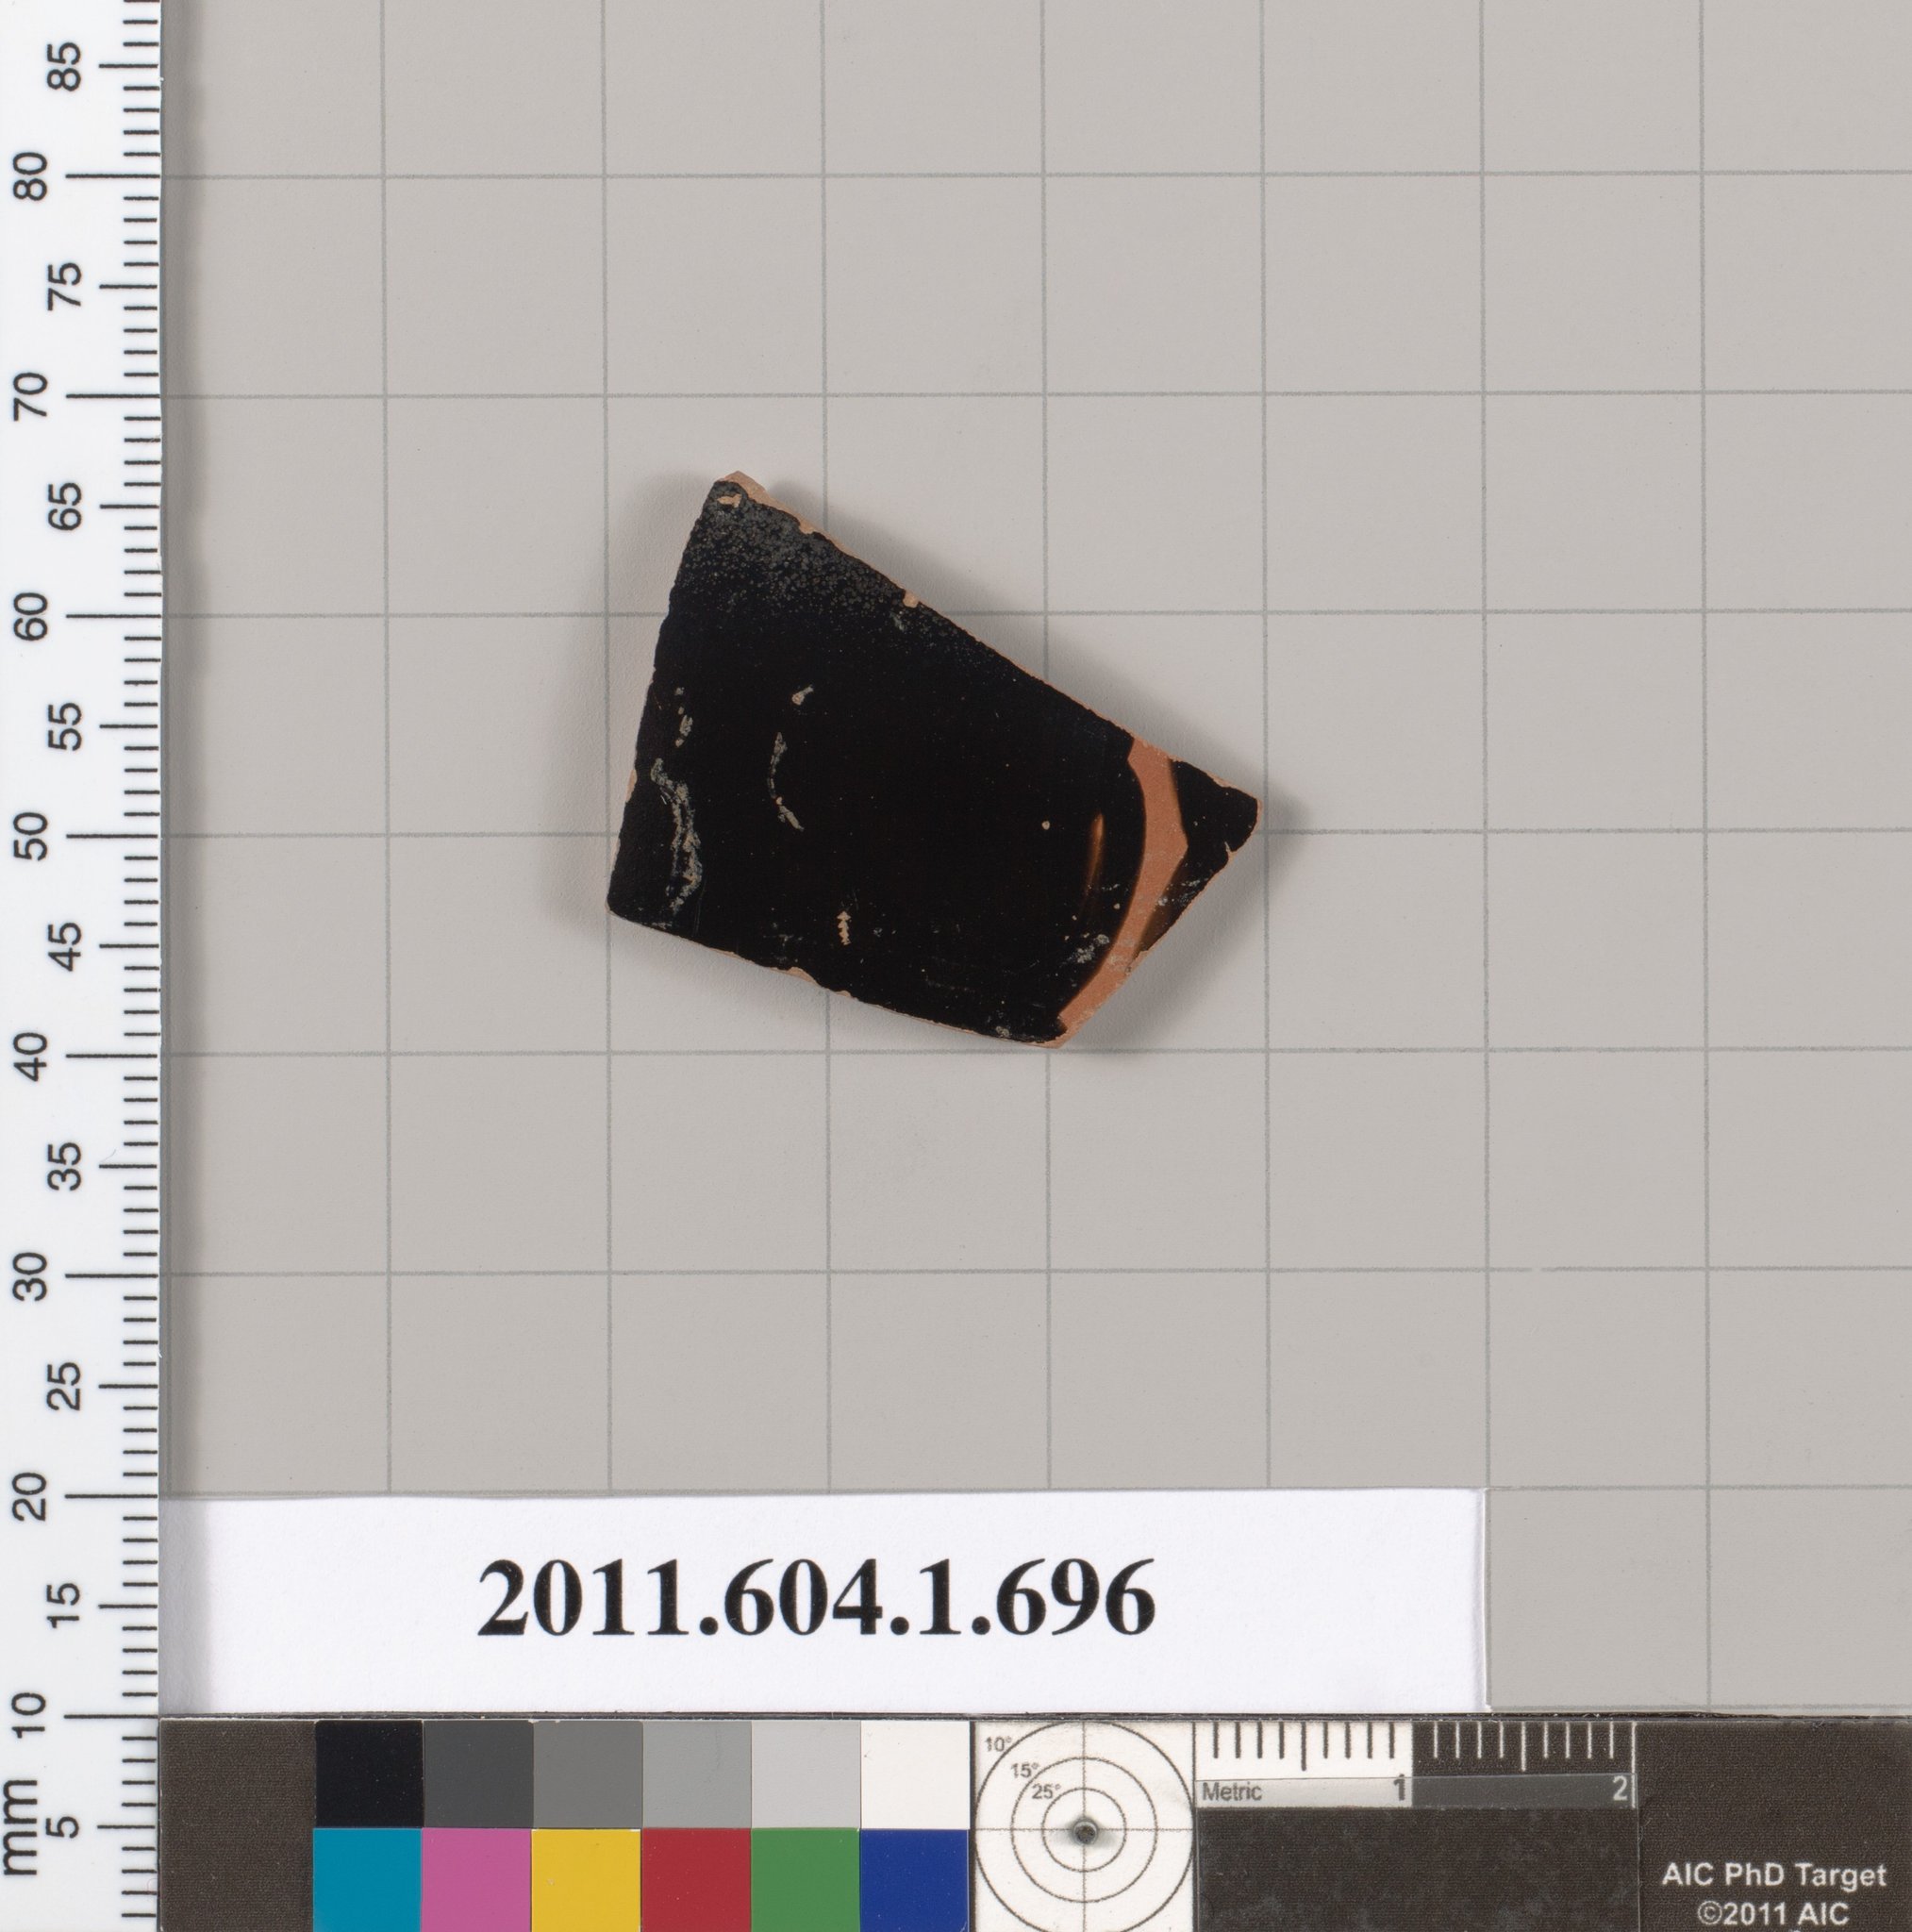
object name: kylix fragment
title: Terracotta fragment of a kylix (drinking cup)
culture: greek, attic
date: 475-451 BCE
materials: terracotta